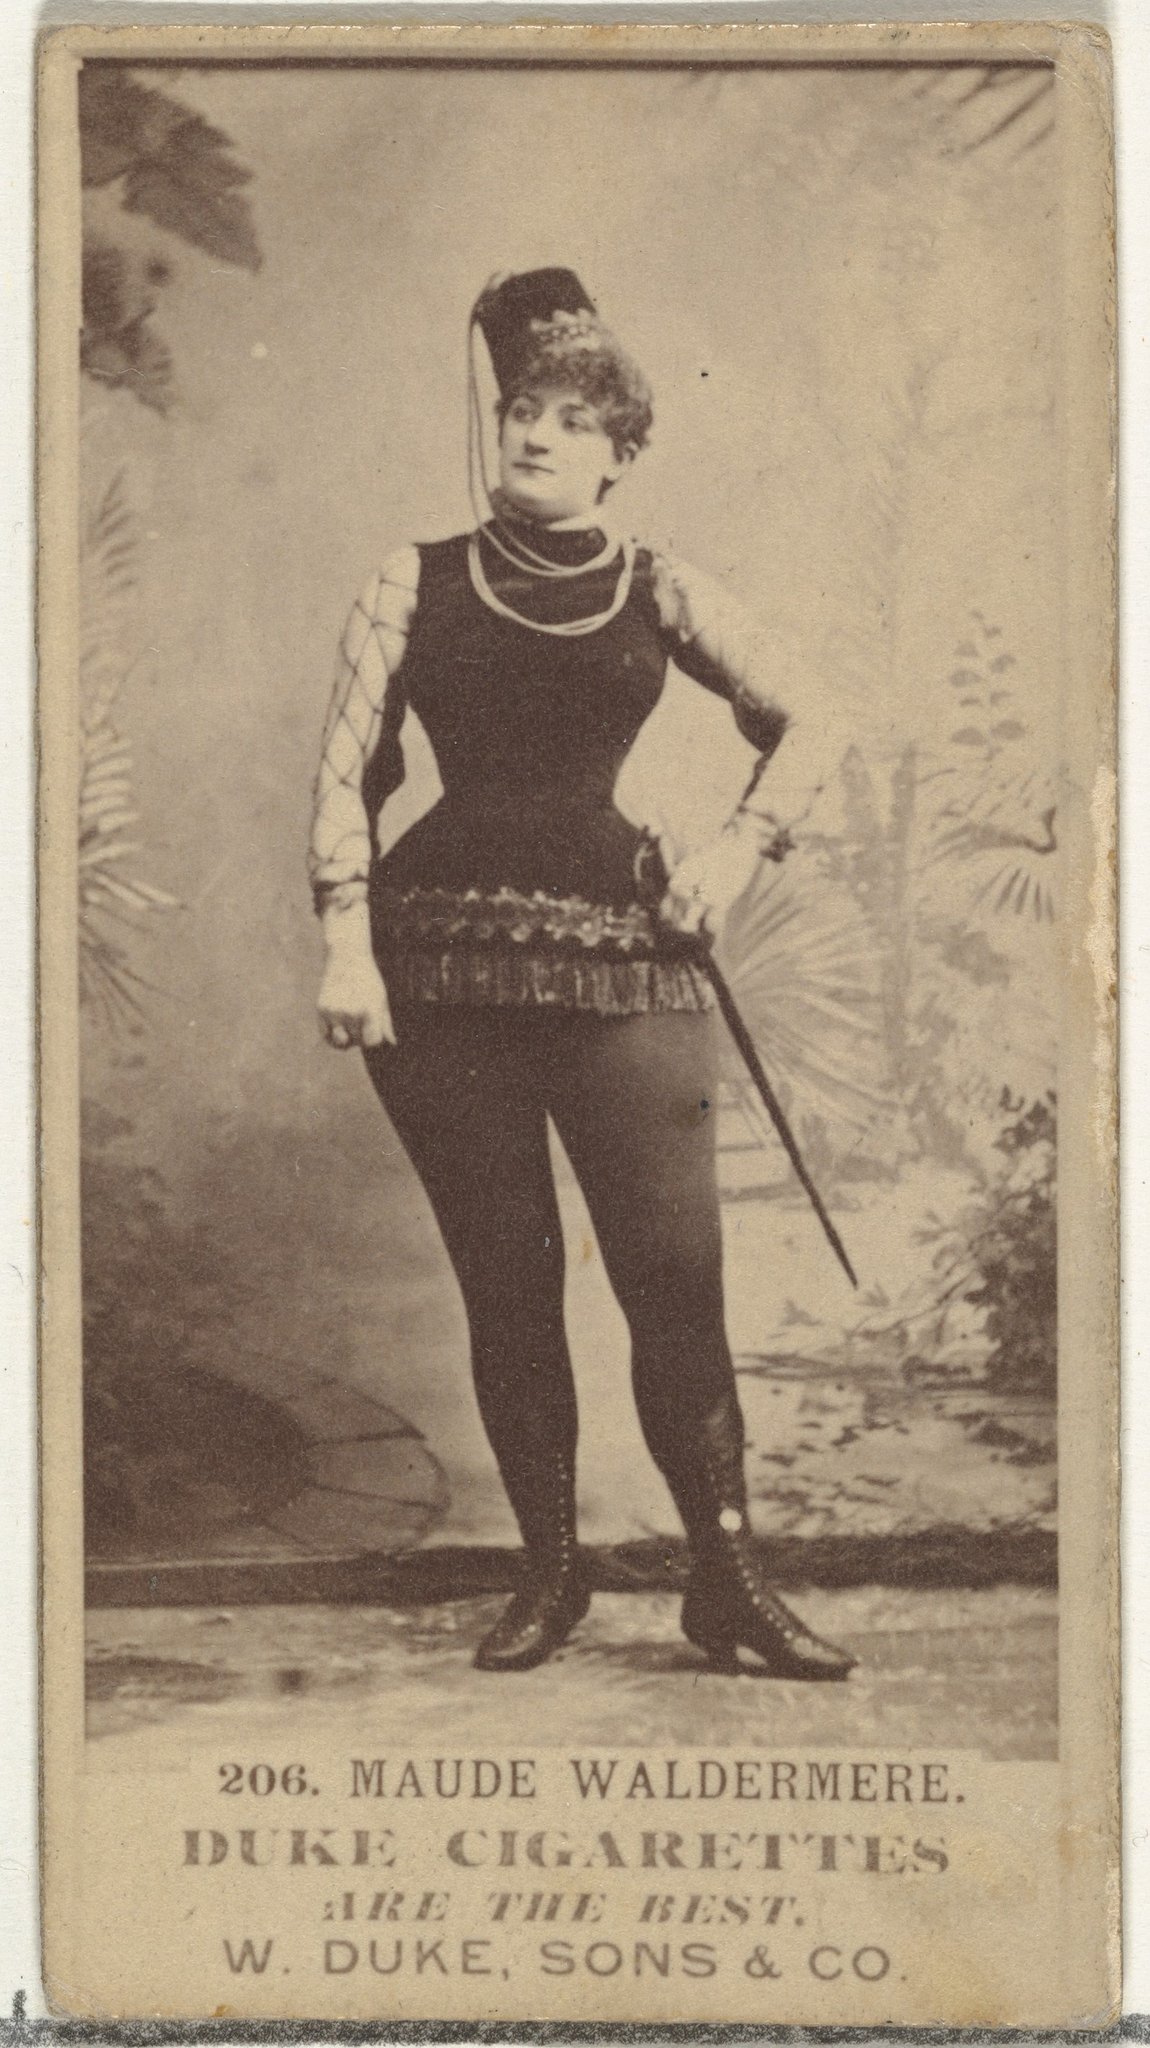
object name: photograph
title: Card Number 206, Maude Waldermere, from the Actors and Actresses series (N145-7) issued by Duke Sons & Co. to promote Duke Cigarettes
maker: w. duke, sons & co.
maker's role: publisher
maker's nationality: american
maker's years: 1870-1920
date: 1880-1889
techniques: albumen silver print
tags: portraits,women,actresses